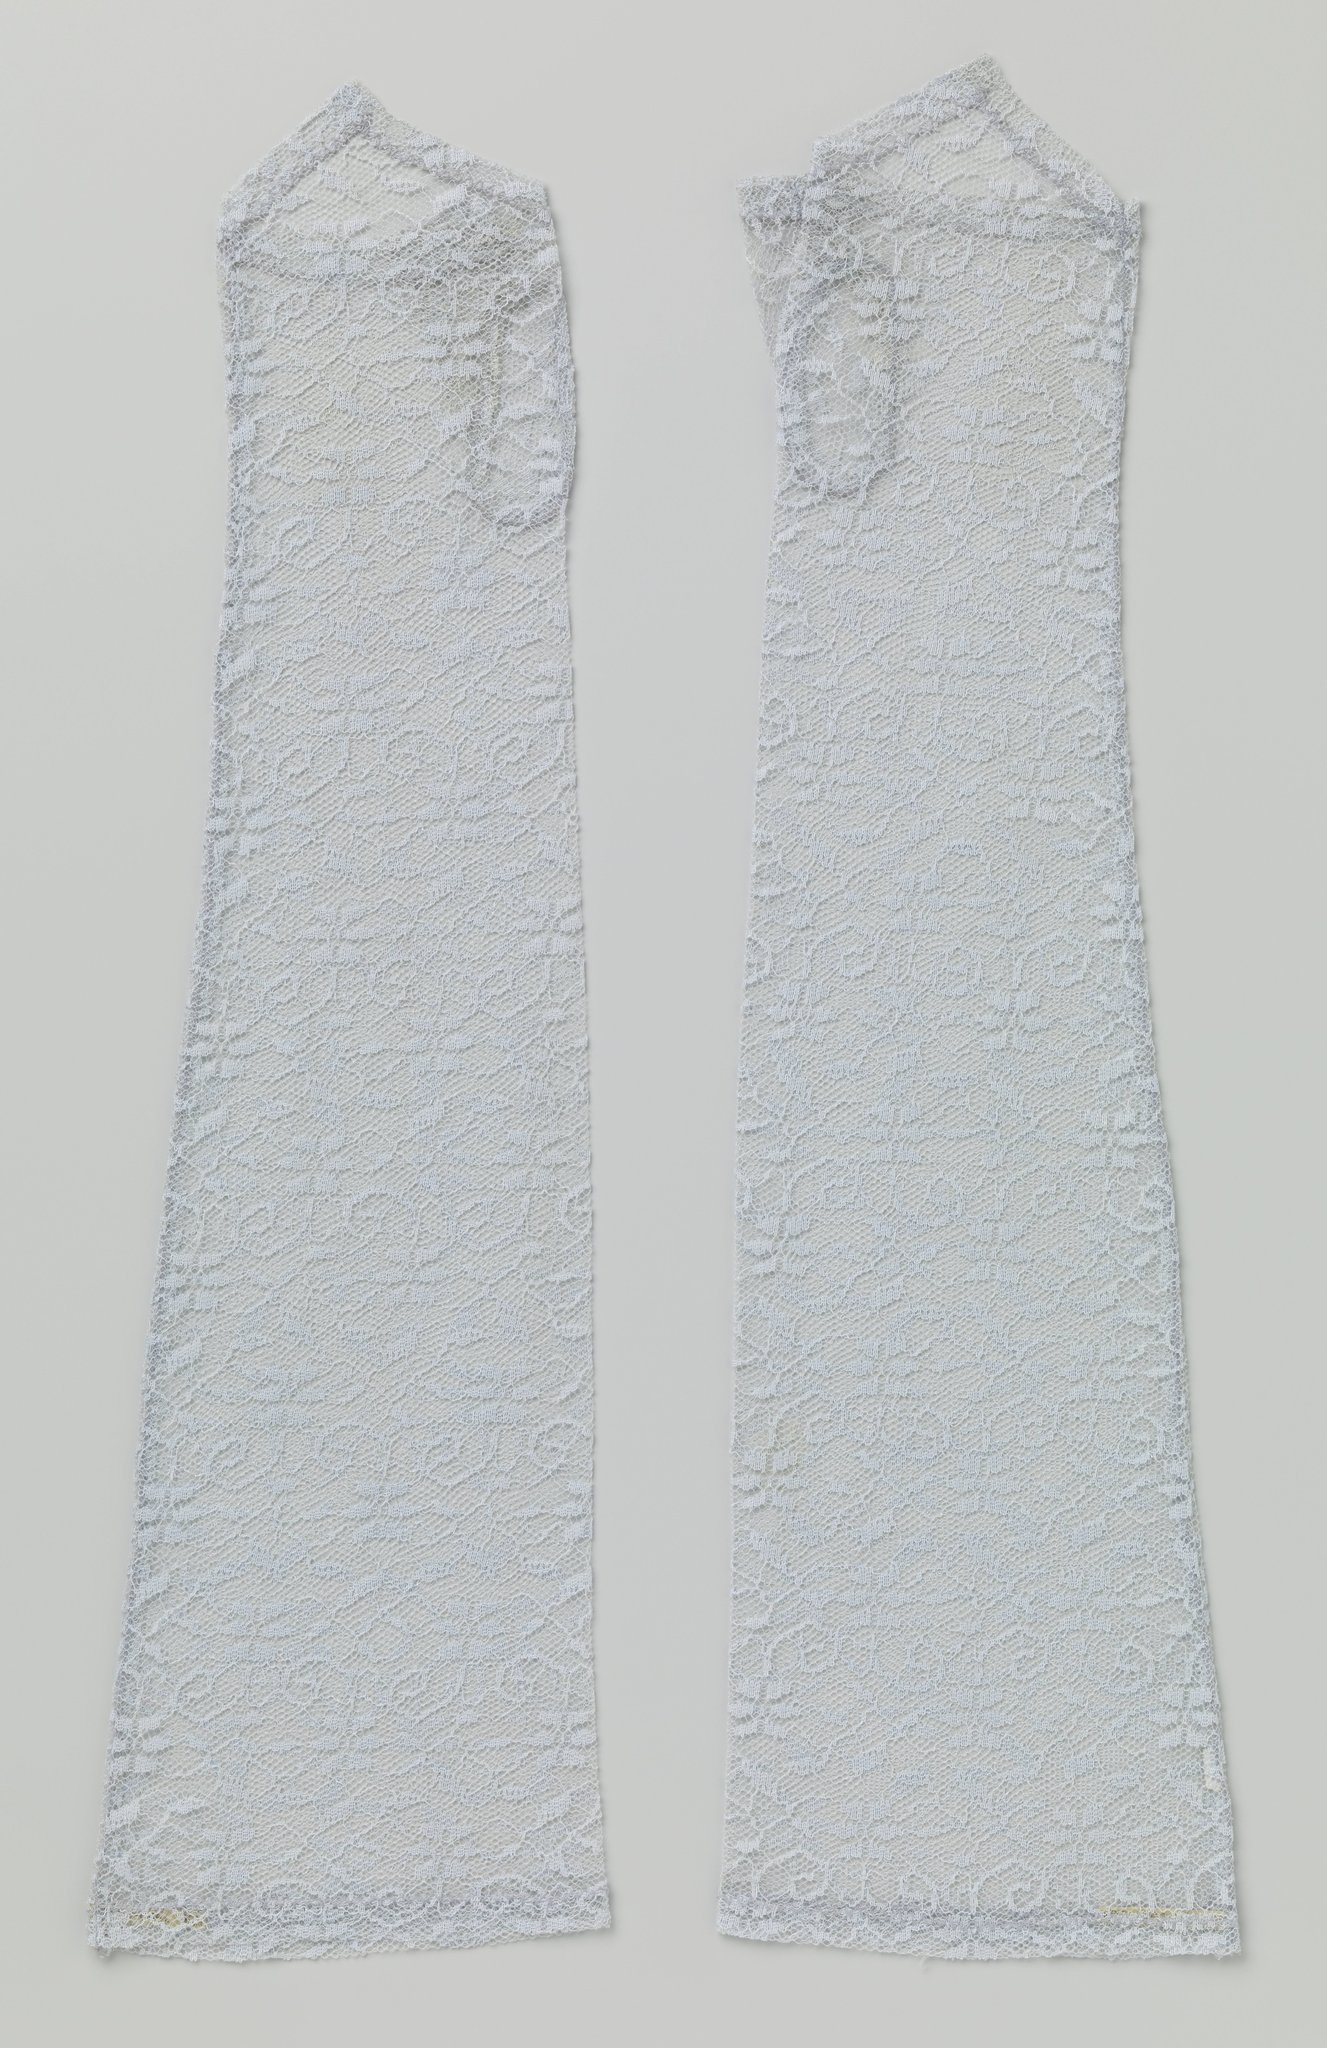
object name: mitt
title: Mitaine van machinale kant, in blauw nylon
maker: Anonymous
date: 1955-1960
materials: cotton, plastic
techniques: weave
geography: netherlands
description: Linker mitaine in blauwe nylon. Uit machinaal vervaardigd kant in bloempatroon.